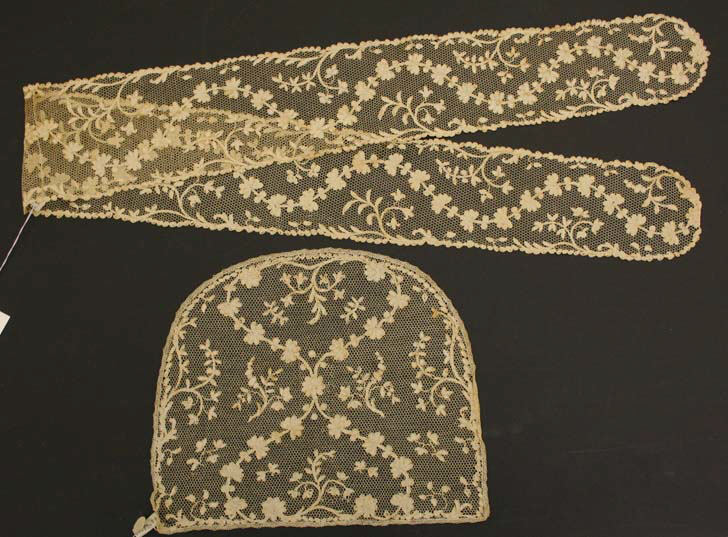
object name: accessory set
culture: french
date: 1715-1774